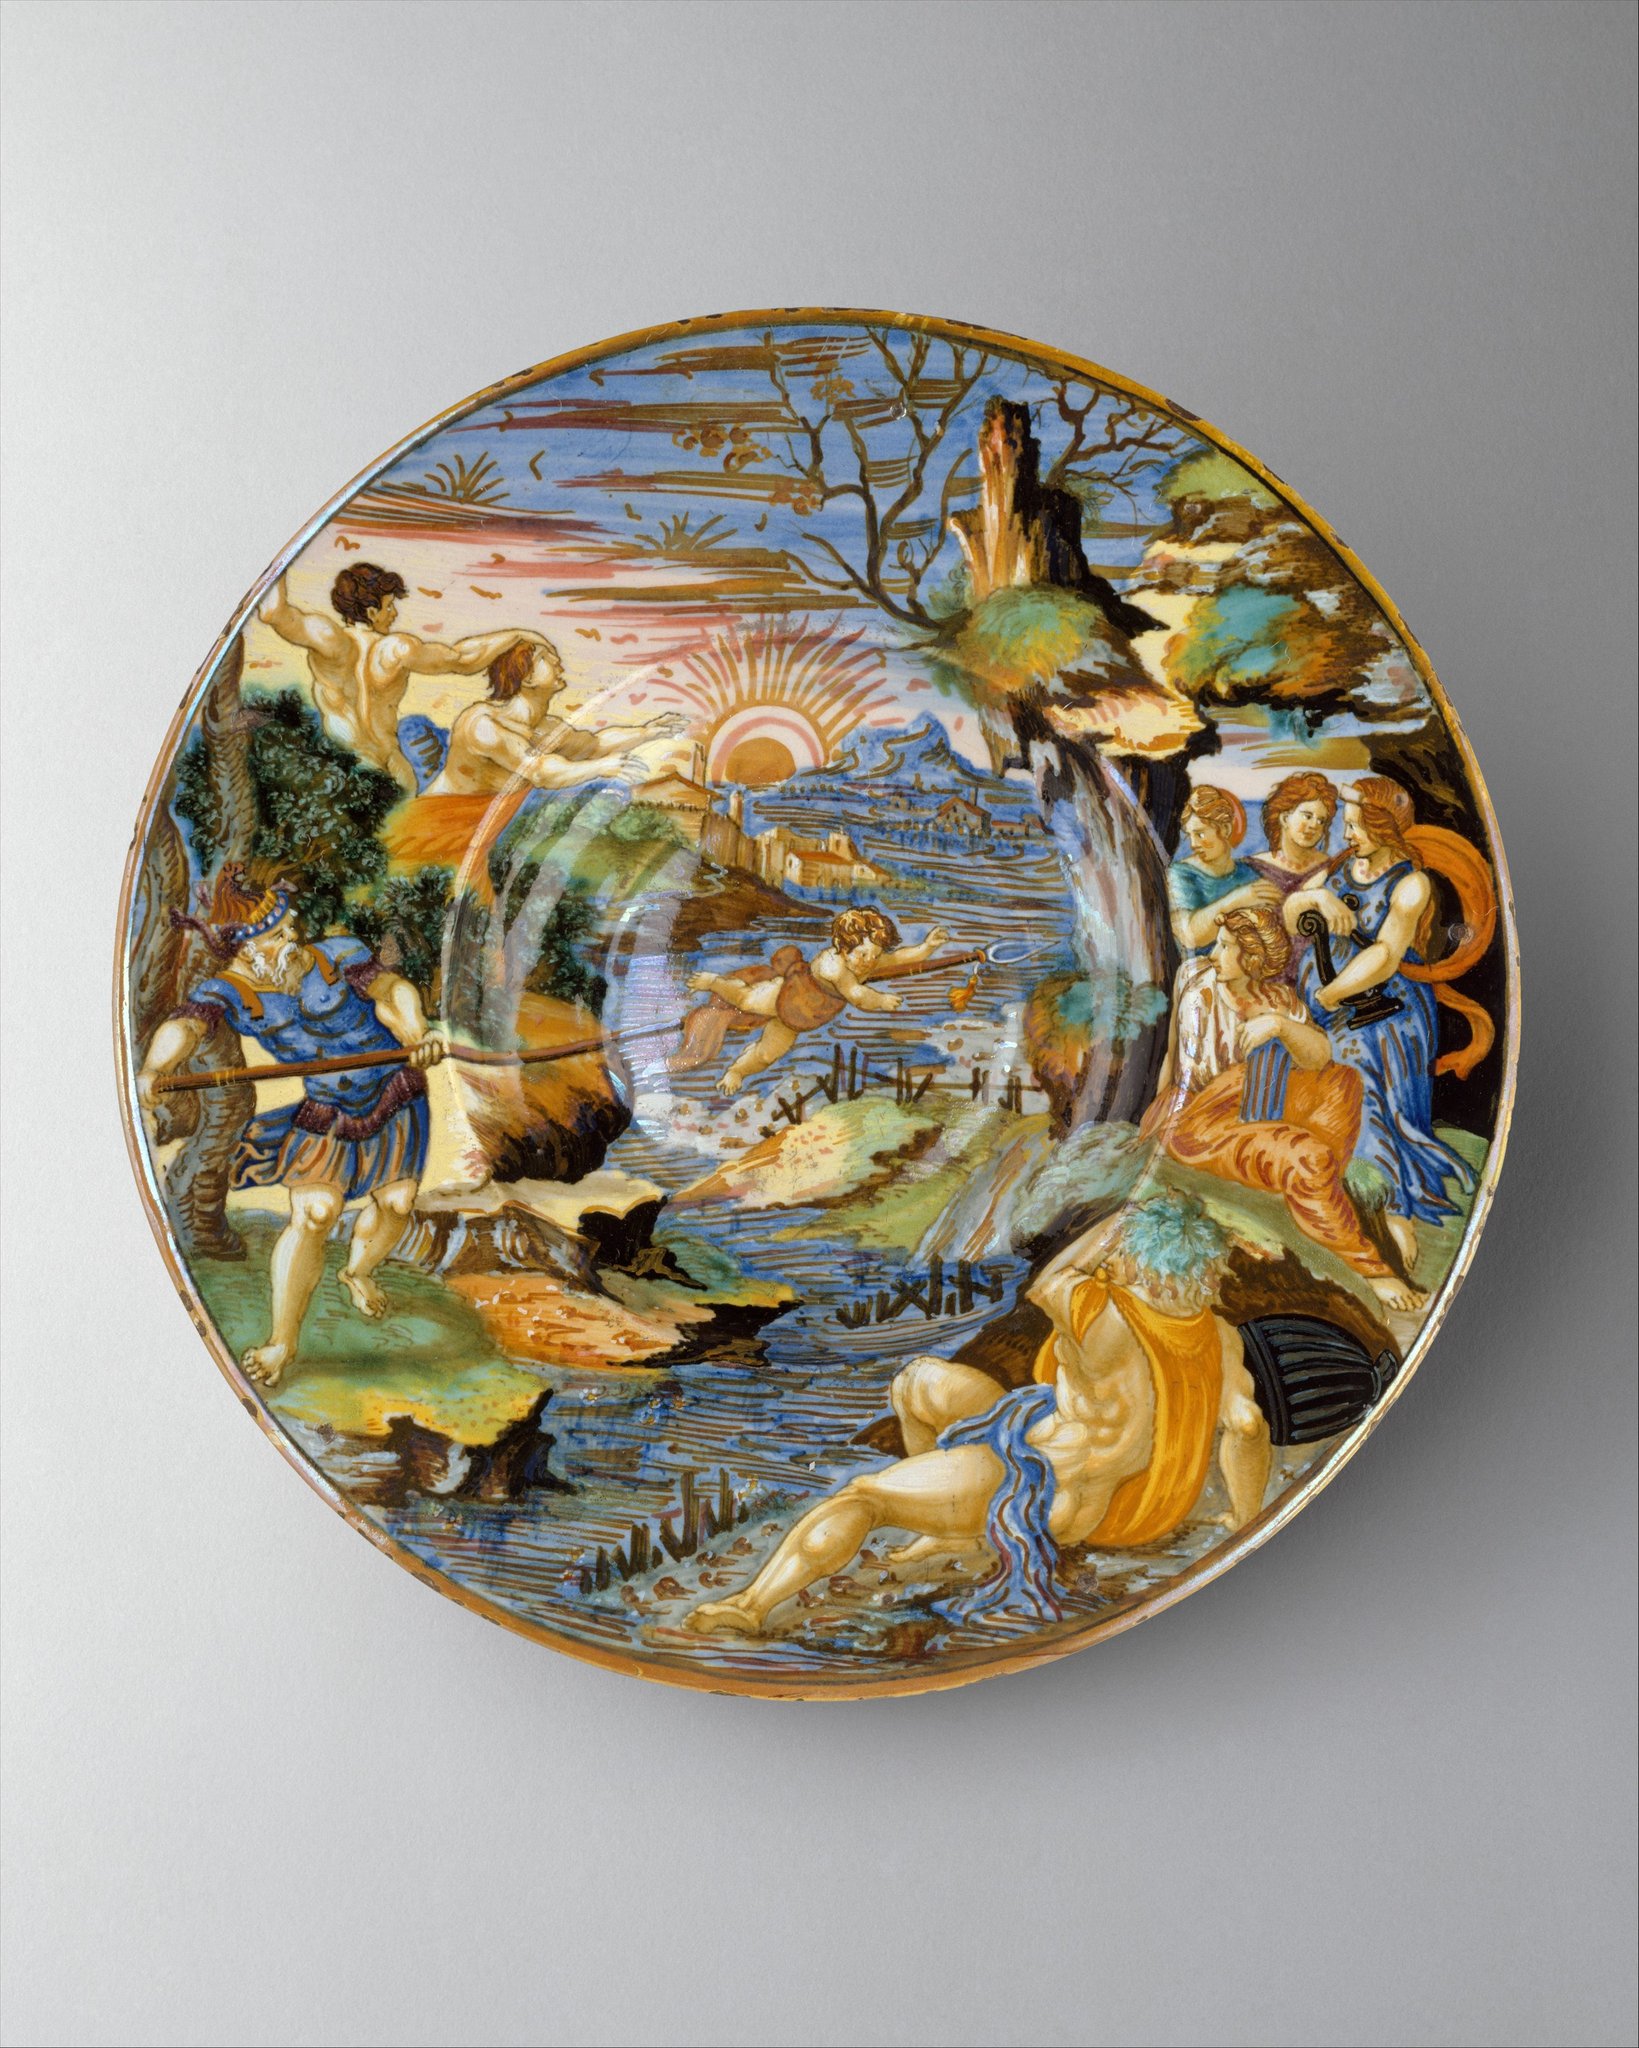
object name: plate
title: Plate (tagliere)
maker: francesco xanto avelli da rovigo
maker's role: artist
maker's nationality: italian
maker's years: 1482-1542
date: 1539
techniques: maiolica, glazing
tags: men,women,rivers